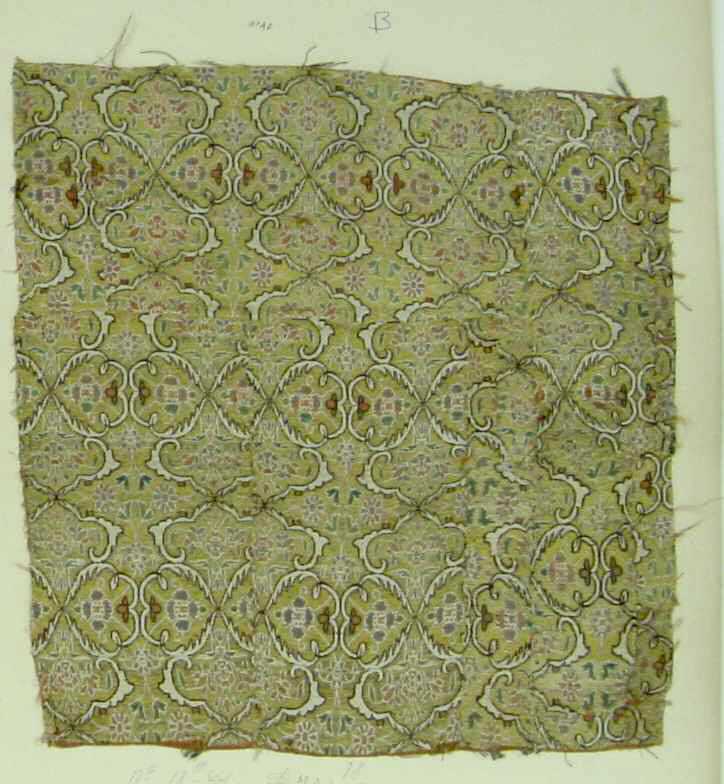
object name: textile fragment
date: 1601-1800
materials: metal thread, silk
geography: iran